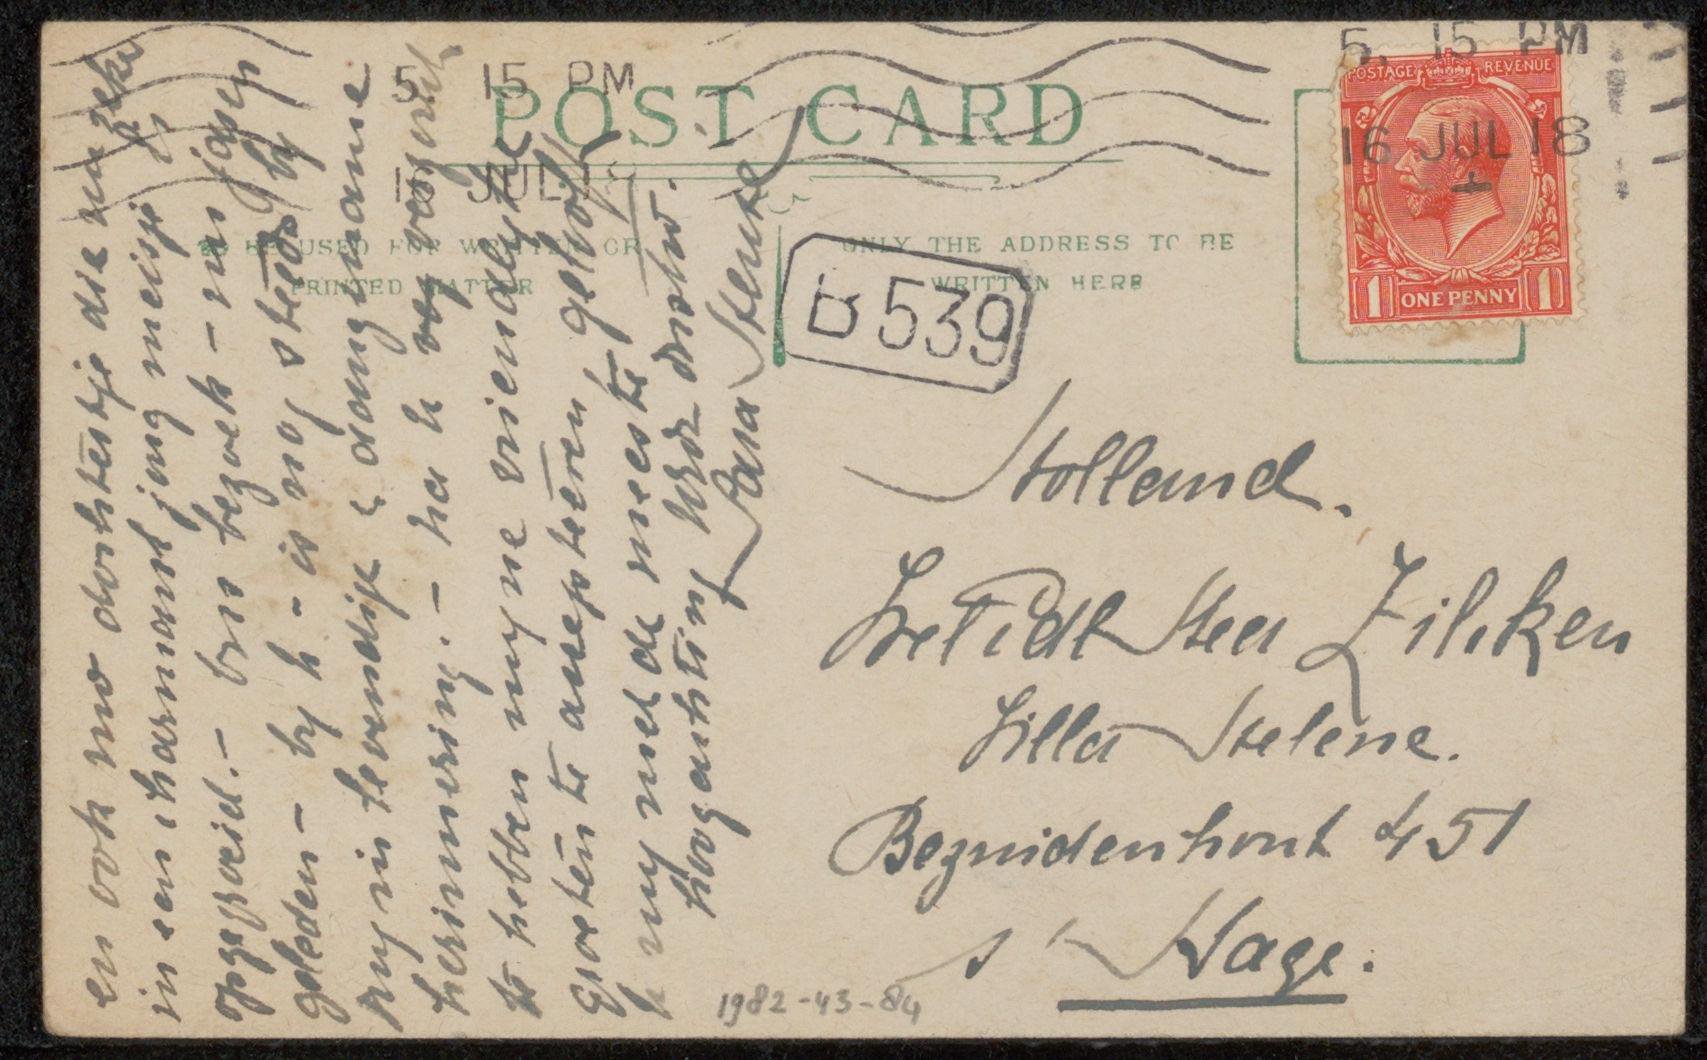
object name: postcard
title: Briefkaart aan Philip Zilcken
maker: sara hense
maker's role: painter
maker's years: 1857-1936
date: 1918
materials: cardboard, ink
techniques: pen, writing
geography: london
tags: gravin olga leutrum von ertingen-okolicsanyi d’okolica, draughtsman, philip zilcken, leiden